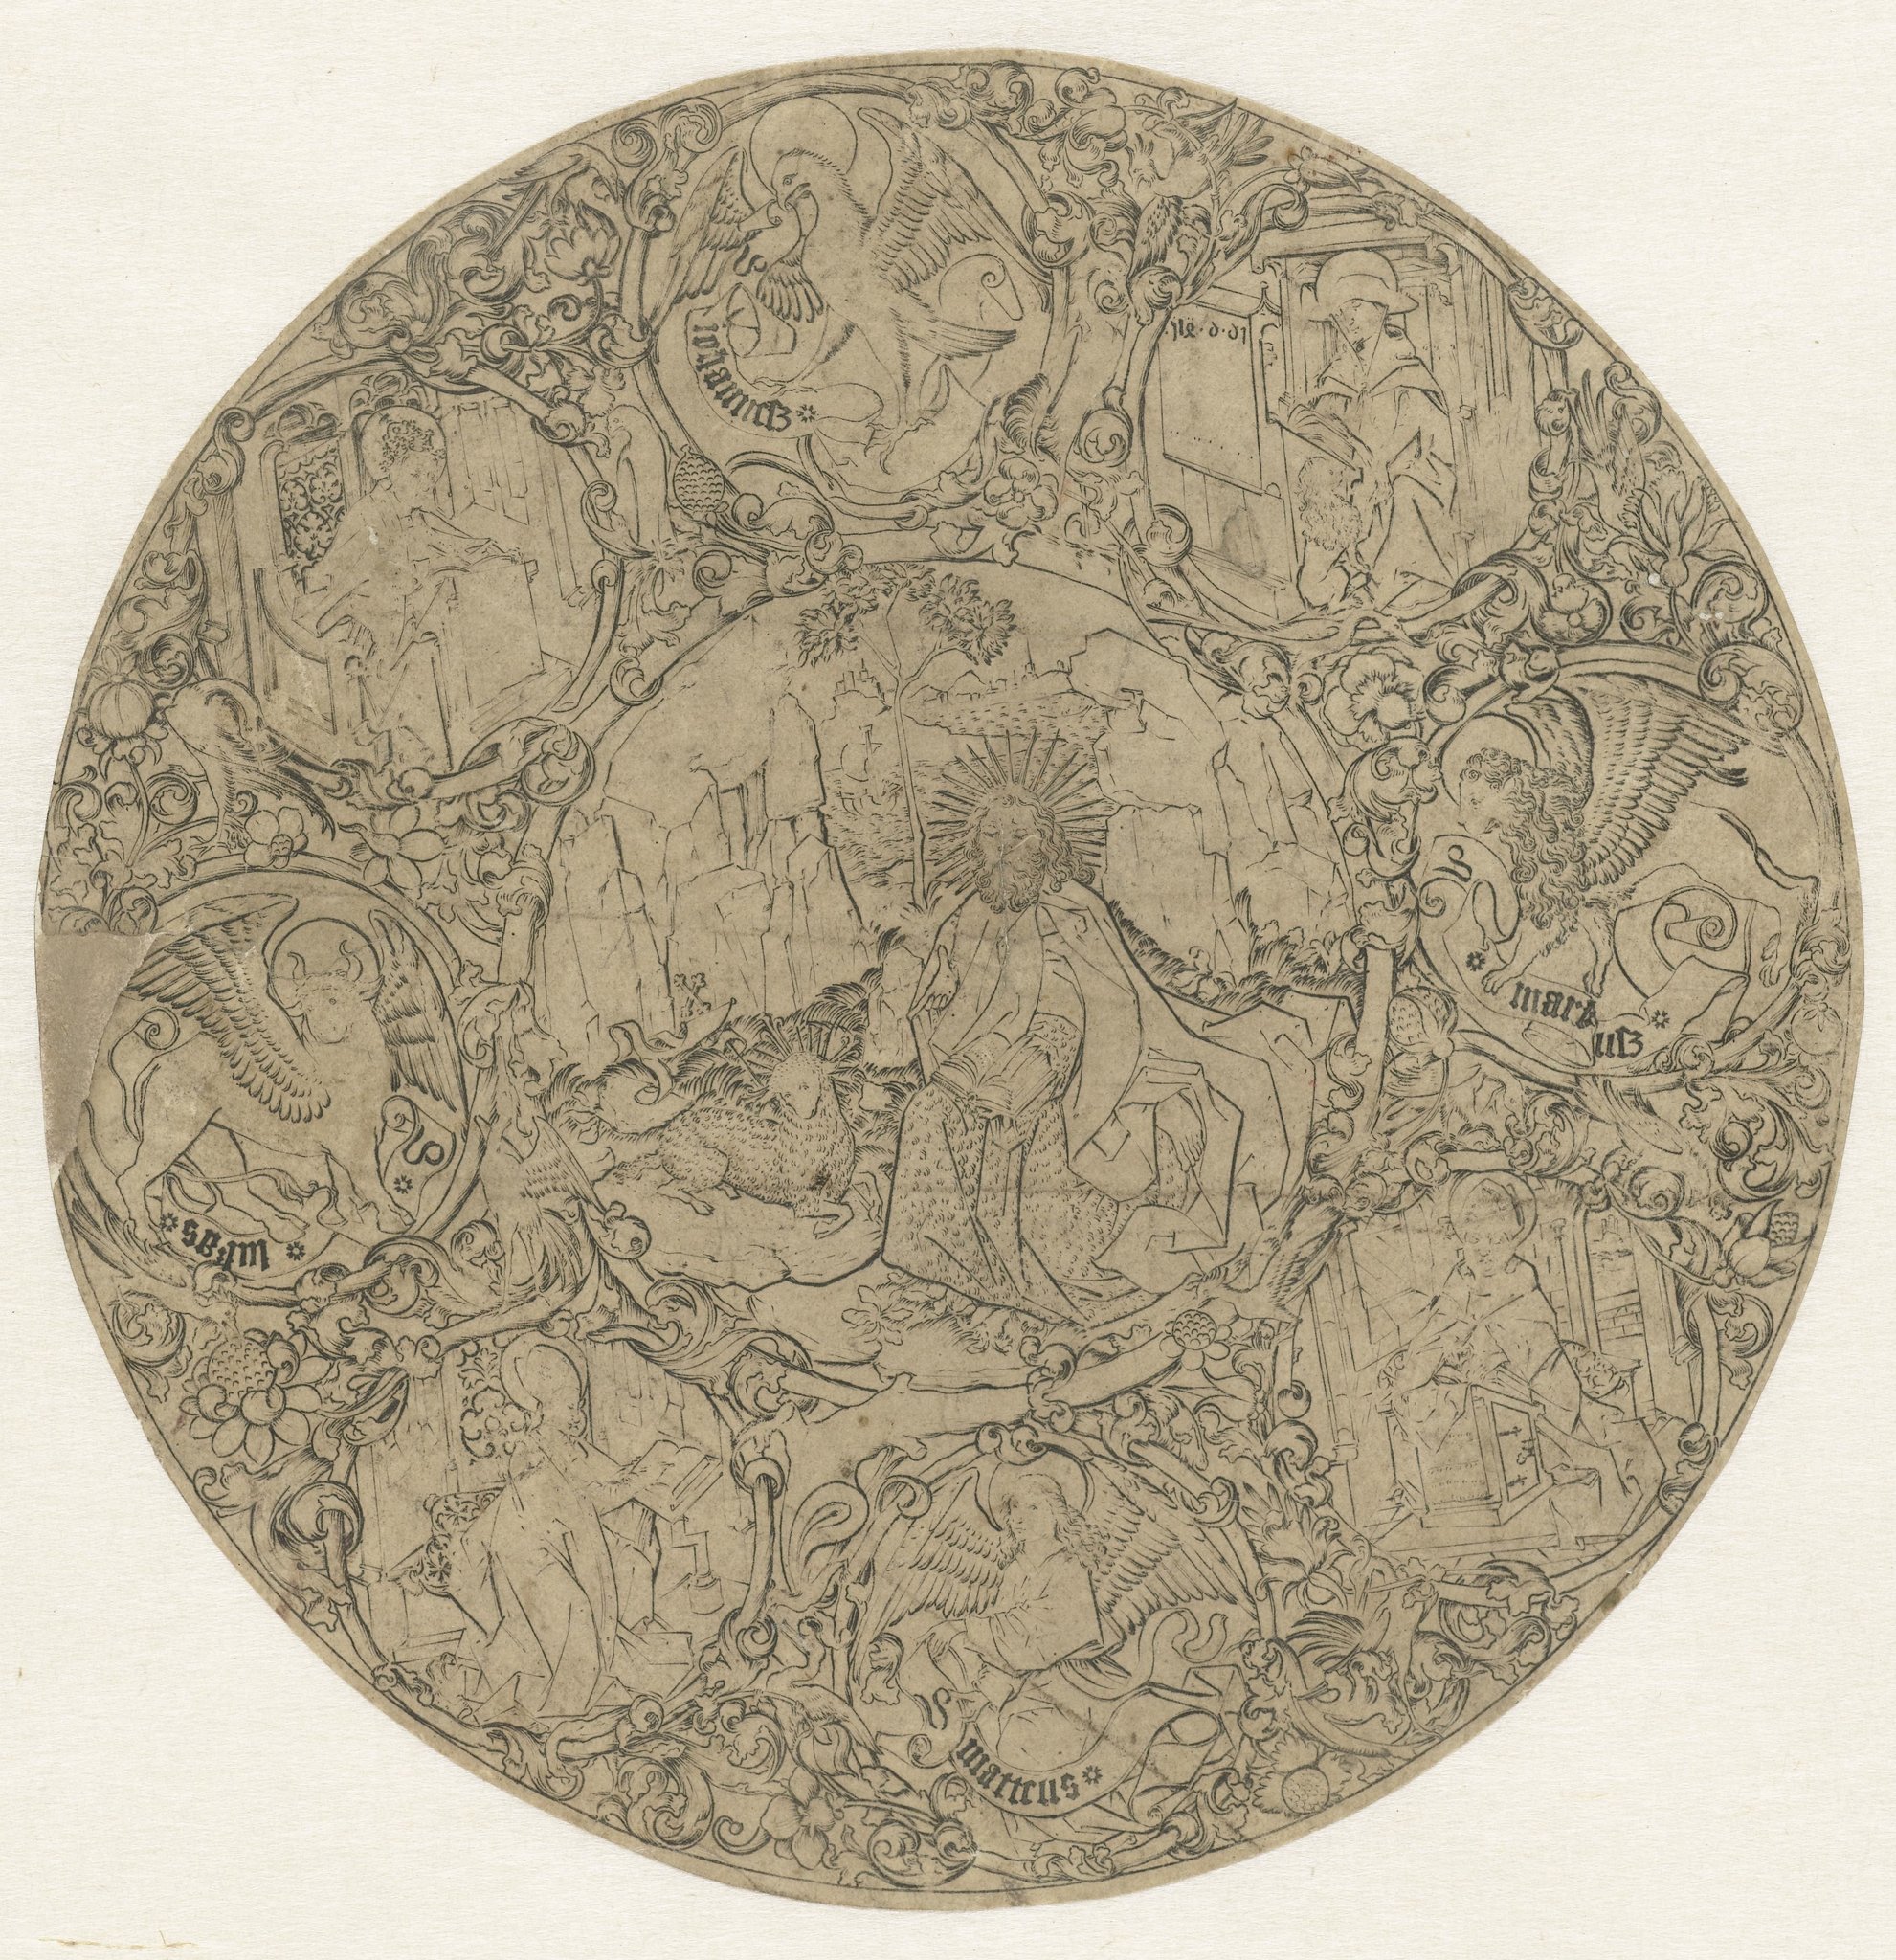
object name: print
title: Johannes de Doper in de woestijn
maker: meester e.s.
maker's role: print maker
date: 1466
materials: paper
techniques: engraving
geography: germany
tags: the four latin (western) fathers of the church together: ambrose (usually as bishop), jerome (usually as cardinal), augustine (usually as bishop), gregory the great (usually as pope), john the baptist; possible attributes: book, reed cross, baptismal cup, honeycomb, lamb, staff - personal devotion of male saint, the four symbols of the evangelists, 'the apocalyptic beasts'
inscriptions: collector's mark: Lugt 240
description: Ontwerp voor een schaaldecoratie. Johannes de Doper in de woestijn met het passielam, omgeven door de symbolen van de vier evangelisten en vier kerkvaders.